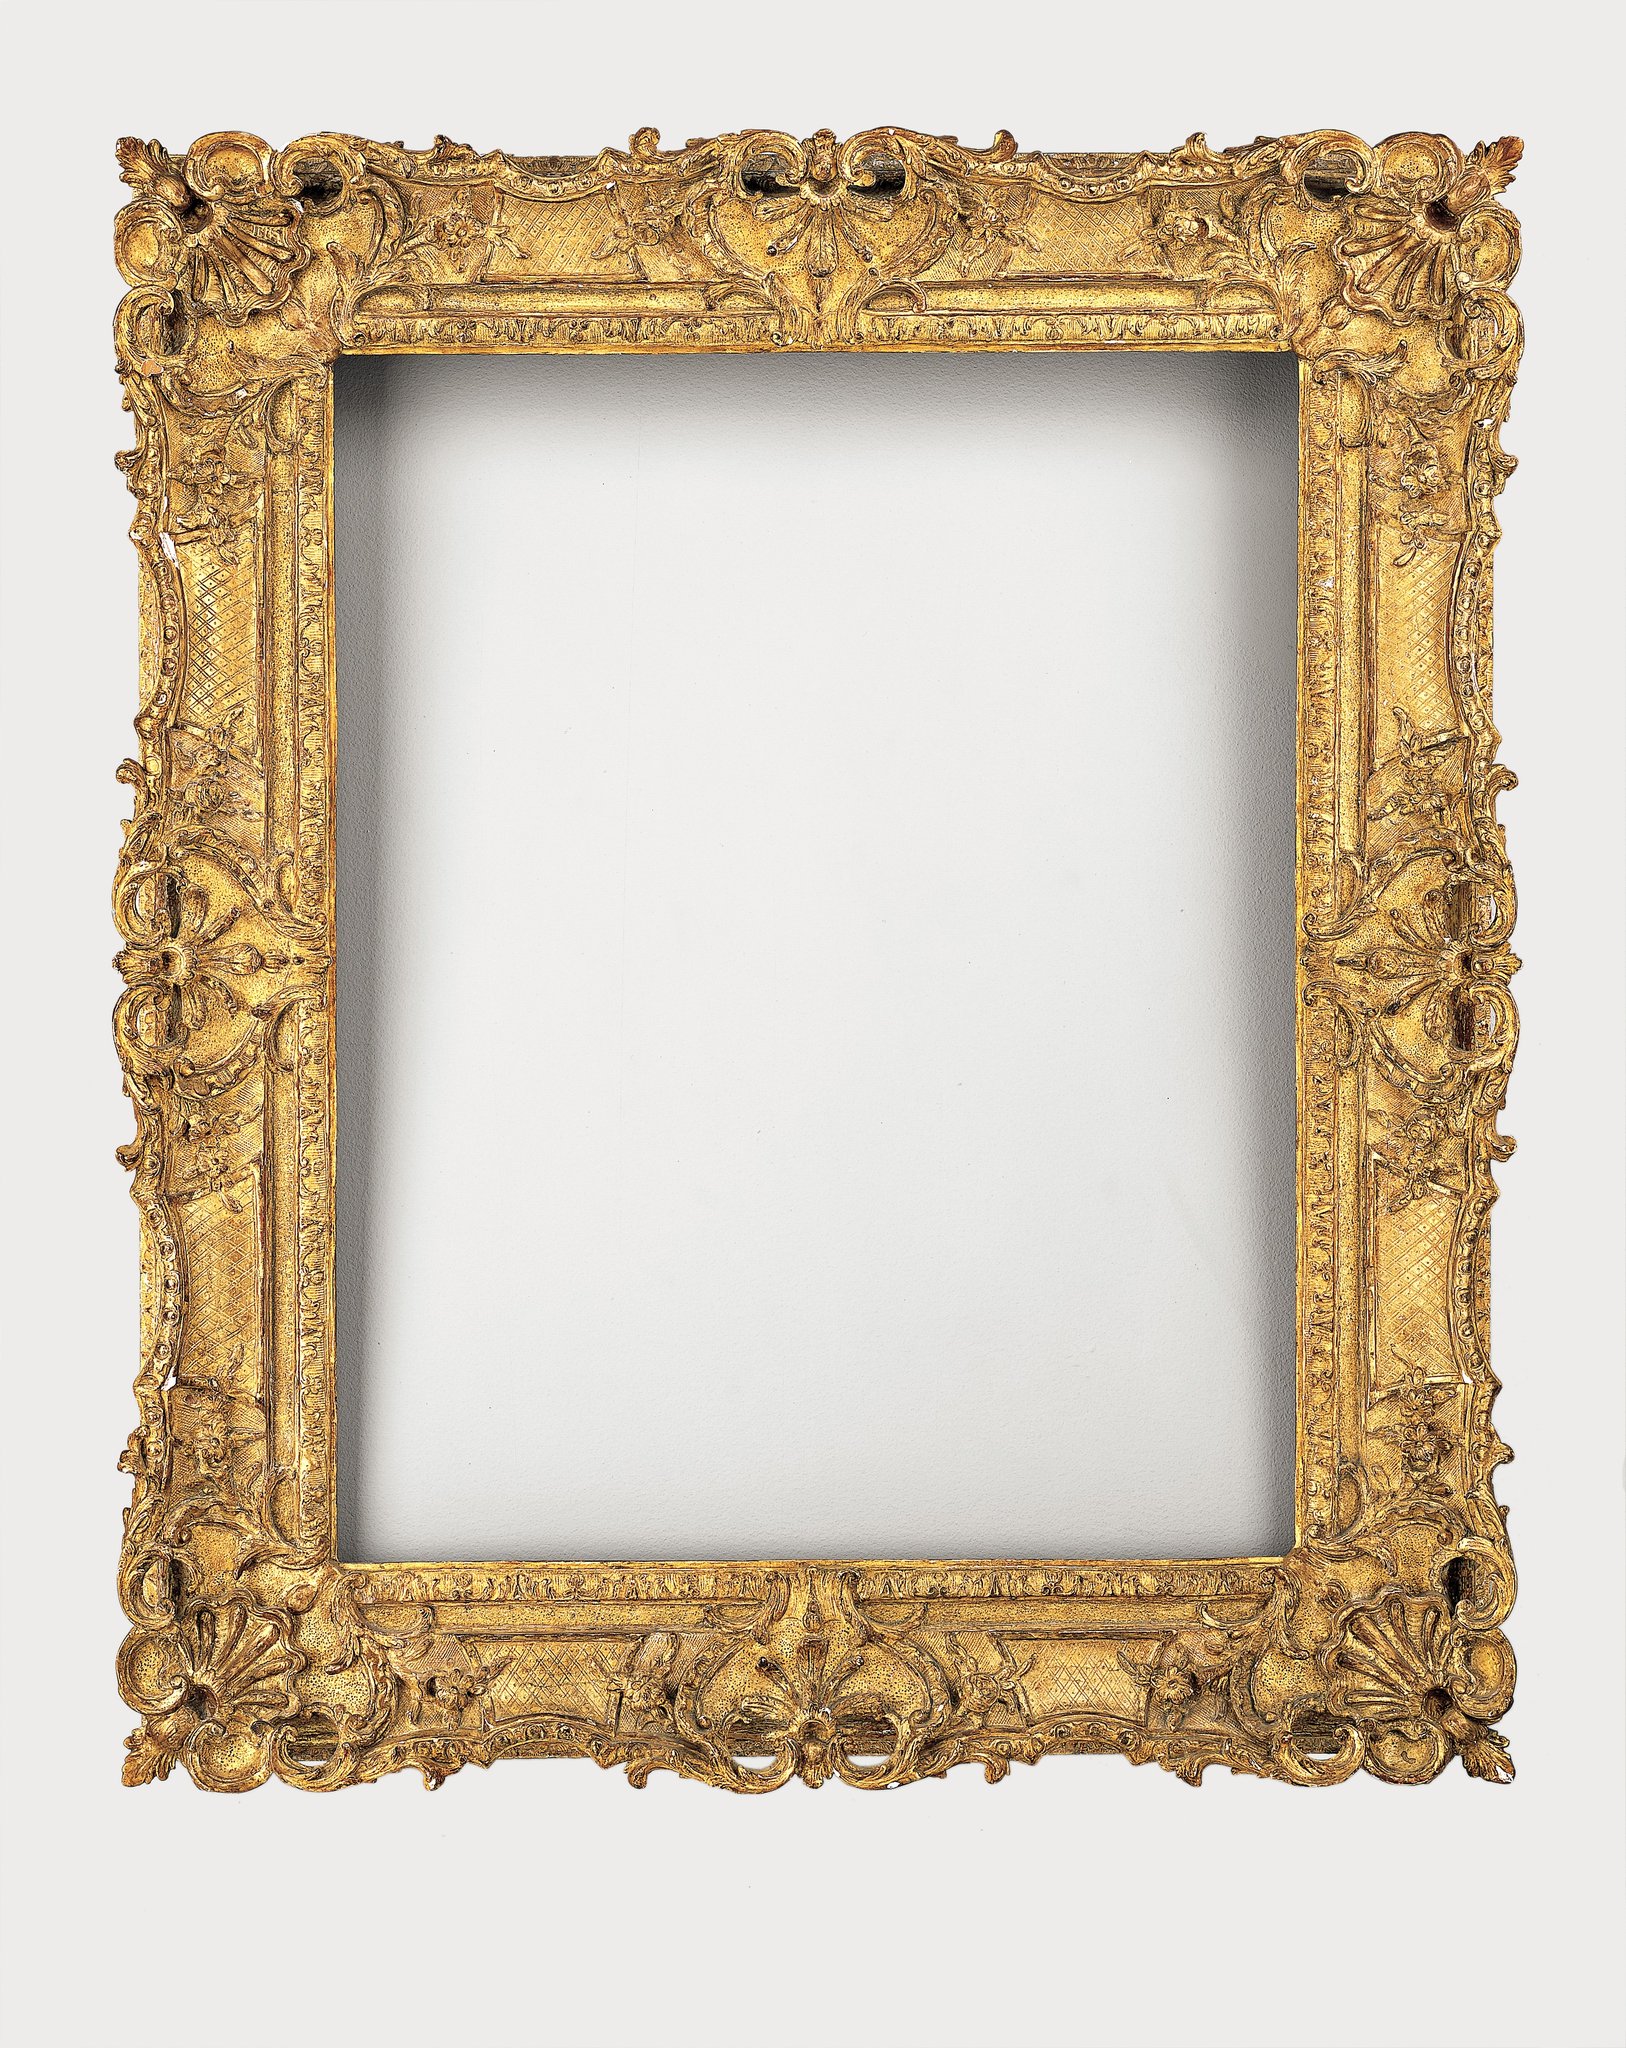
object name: frame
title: Largillière frame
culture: french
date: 1725-1730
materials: feather, wood